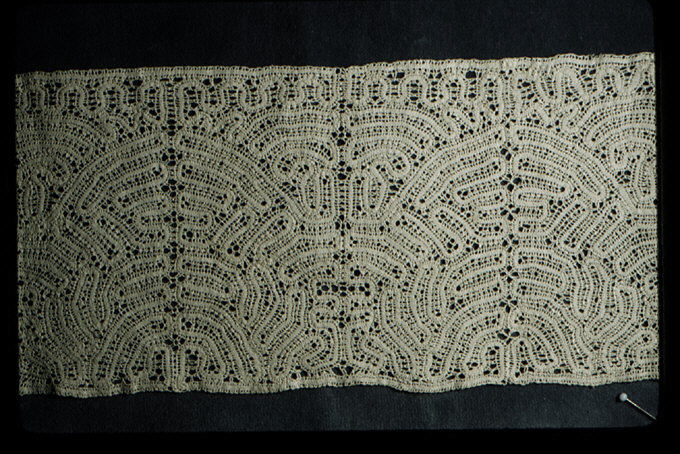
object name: fragment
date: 1701-1800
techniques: lace